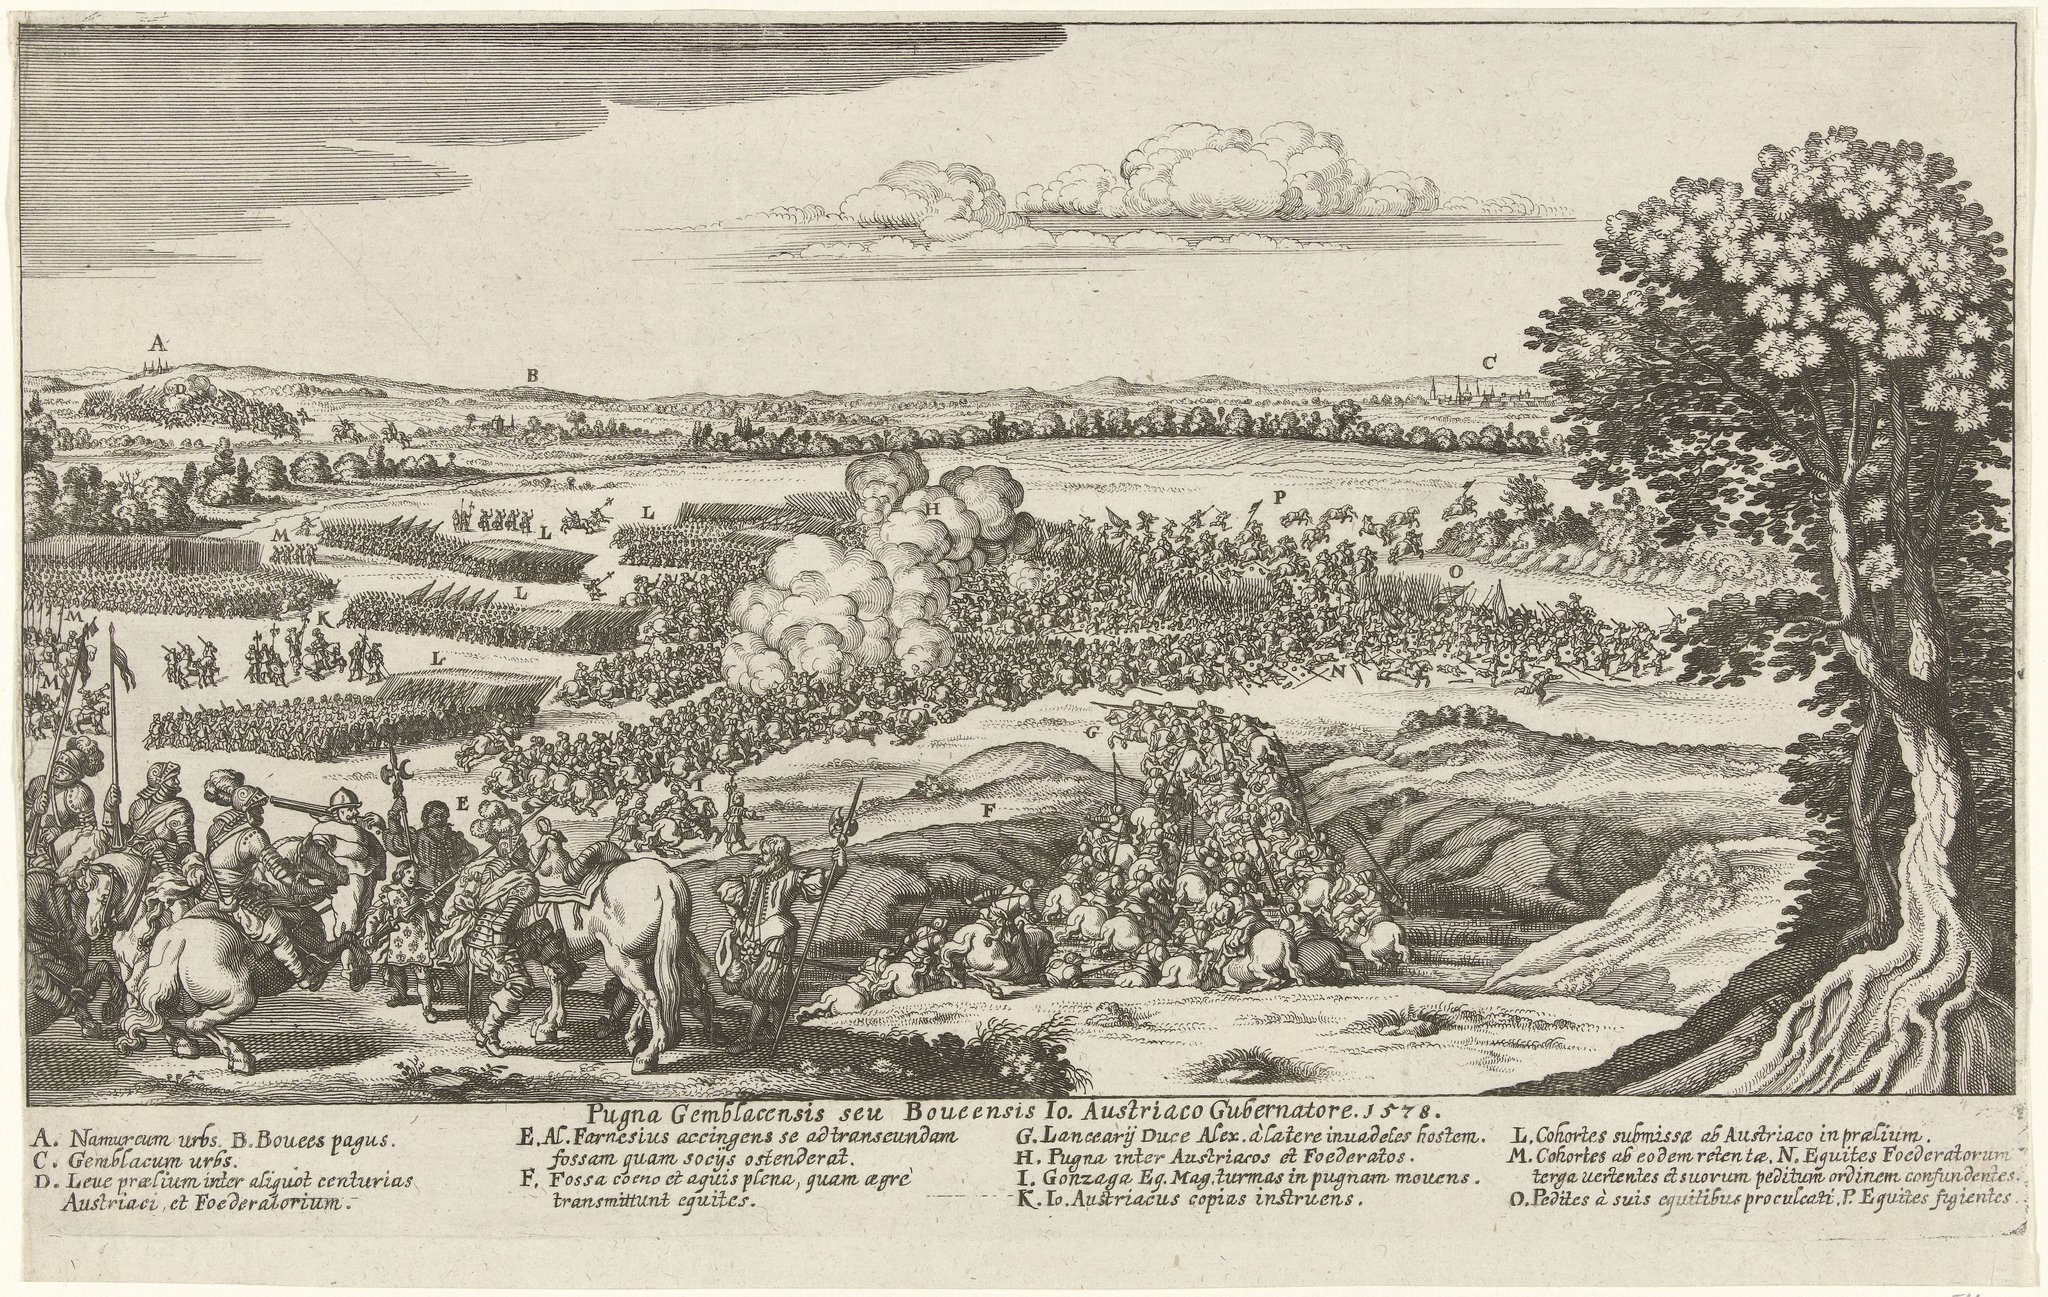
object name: print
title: Slag bij Gembloers, 1578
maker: Anonymous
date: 1649-1651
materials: paper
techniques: etching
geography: rome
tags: battle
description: Kopie naar de illustratie in: F. Strada, De Bello belgico decades duae auctiores et correctiores cum figuris encis prodeunt a Famiano Strada Soc: Jesu Romano Moguntiae 1651. Kopie naar de prent van J.W. Baur uit de oorspronkelijke editie van 1632, zie FMH 454A/9 en FMH 769/II.